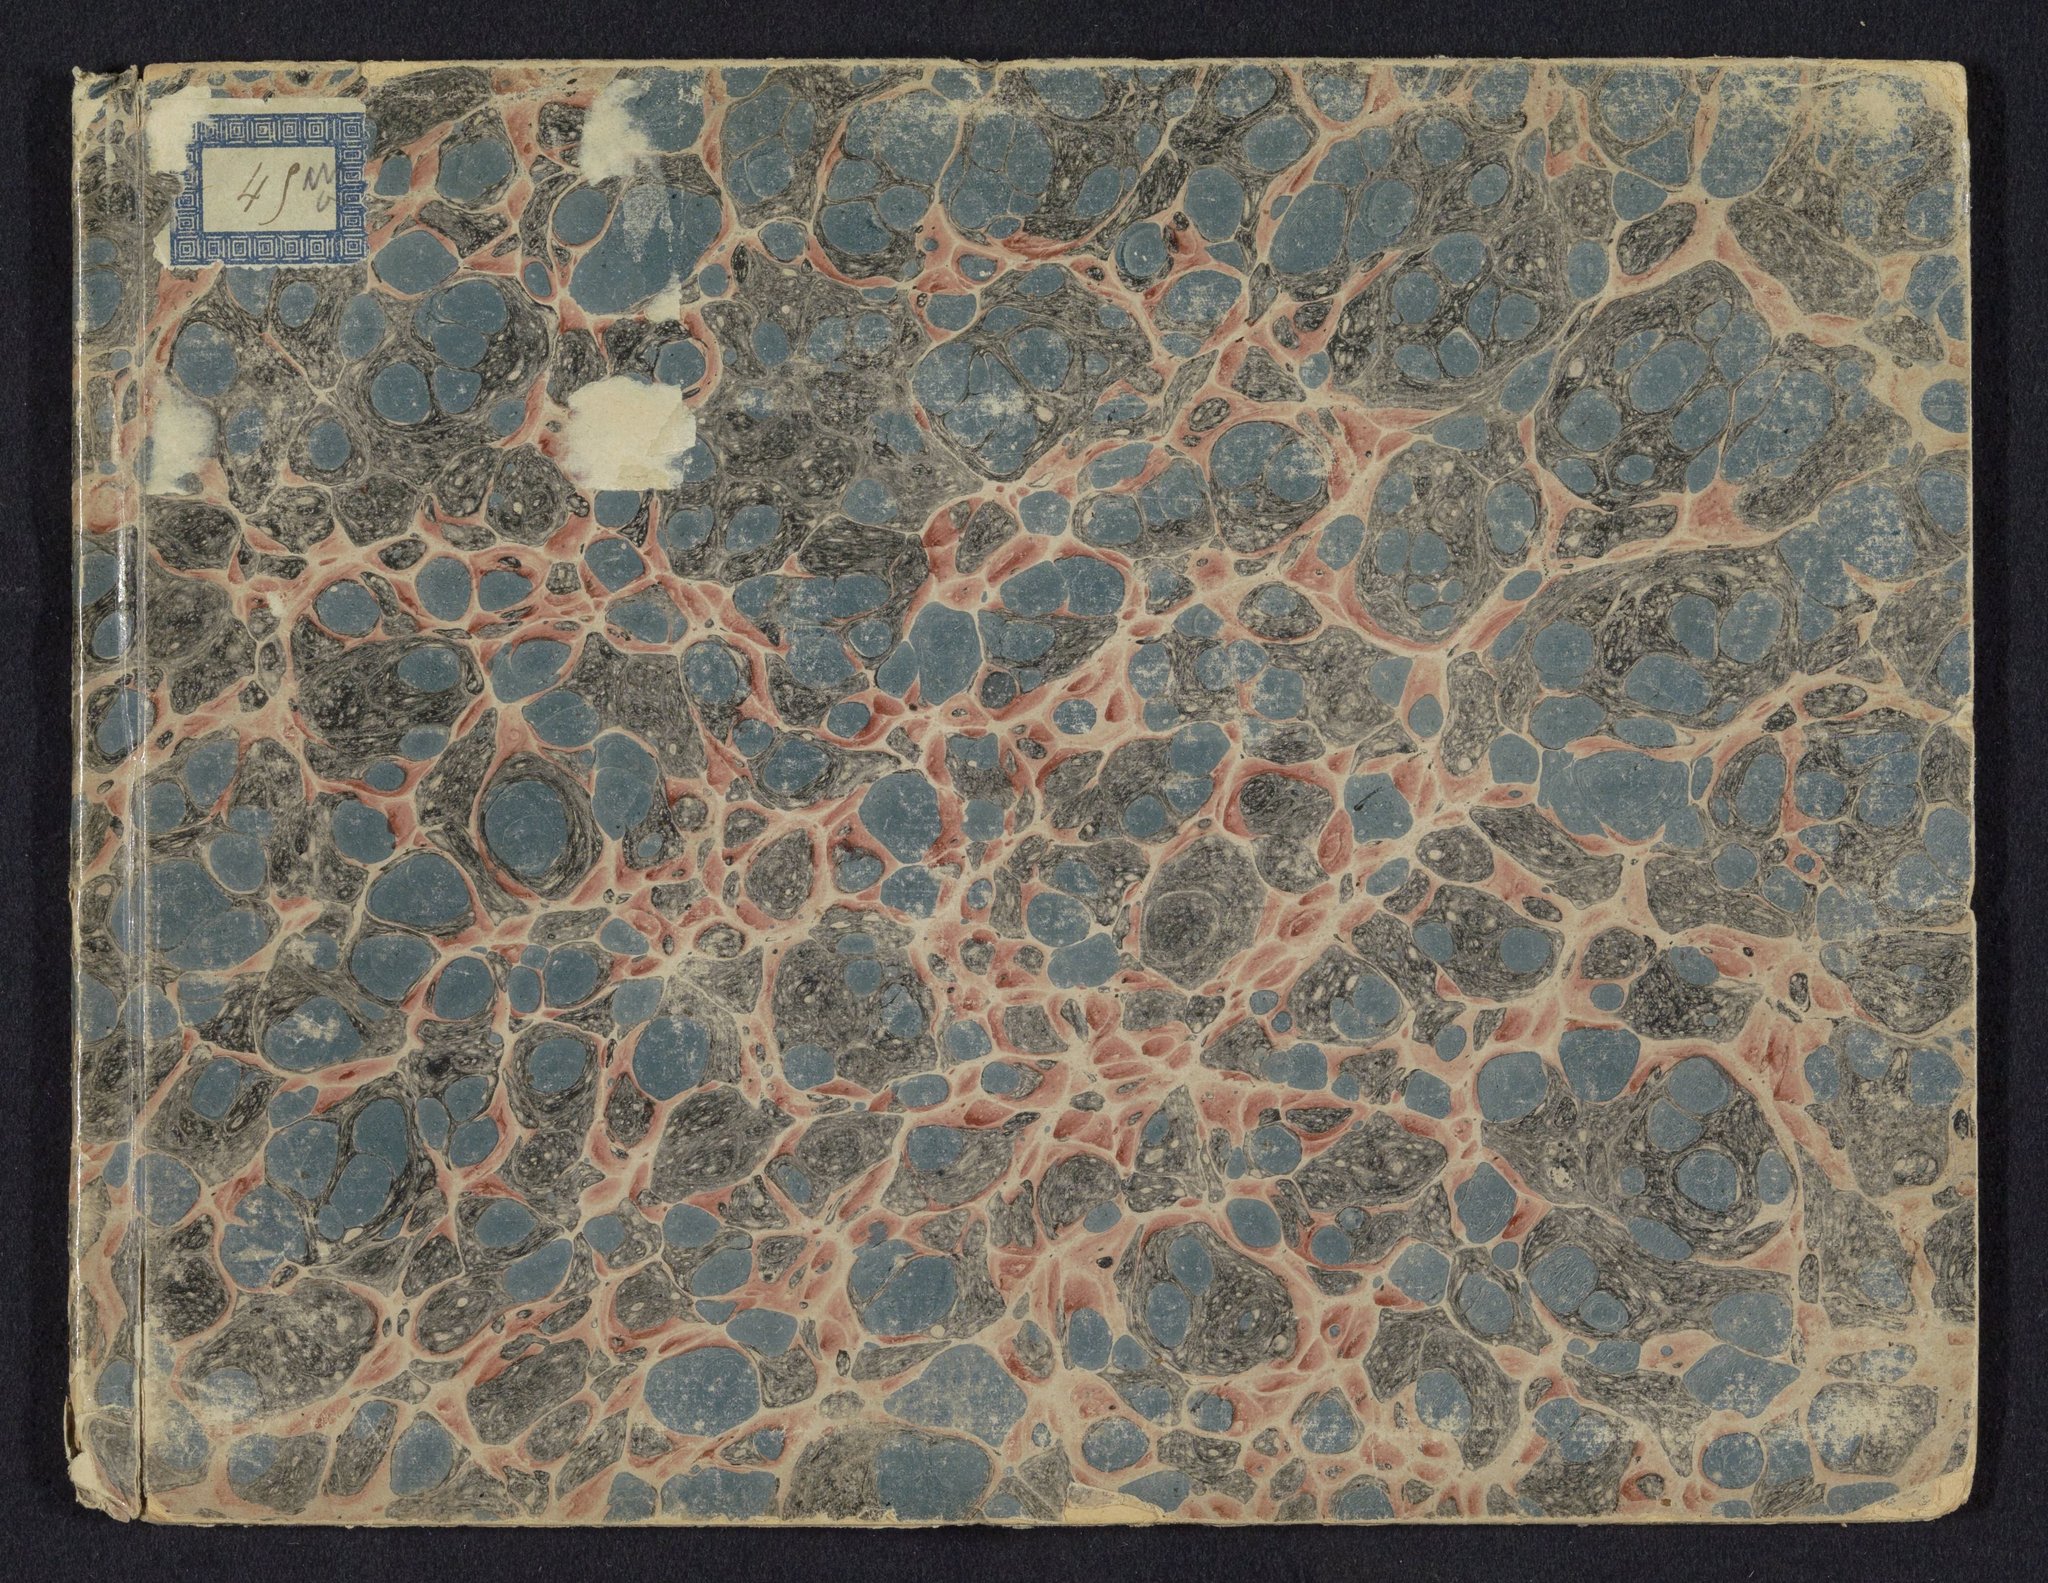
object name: prentrecueil, prentenalbum, prentalbum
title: Album met dertien decorontwerpen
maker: Anonymous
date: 1750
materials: cardboard, paper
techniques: bookbinding, etching, marbling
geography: italy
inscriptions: number: ‘49’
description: Album met 13 prenten op 13 albumbladen. Het album bevat voorstellingen van decorontwerpen. Een kartonnen band, beplakt met marmerpapier, met voor- en achterin een blanco schutblad.